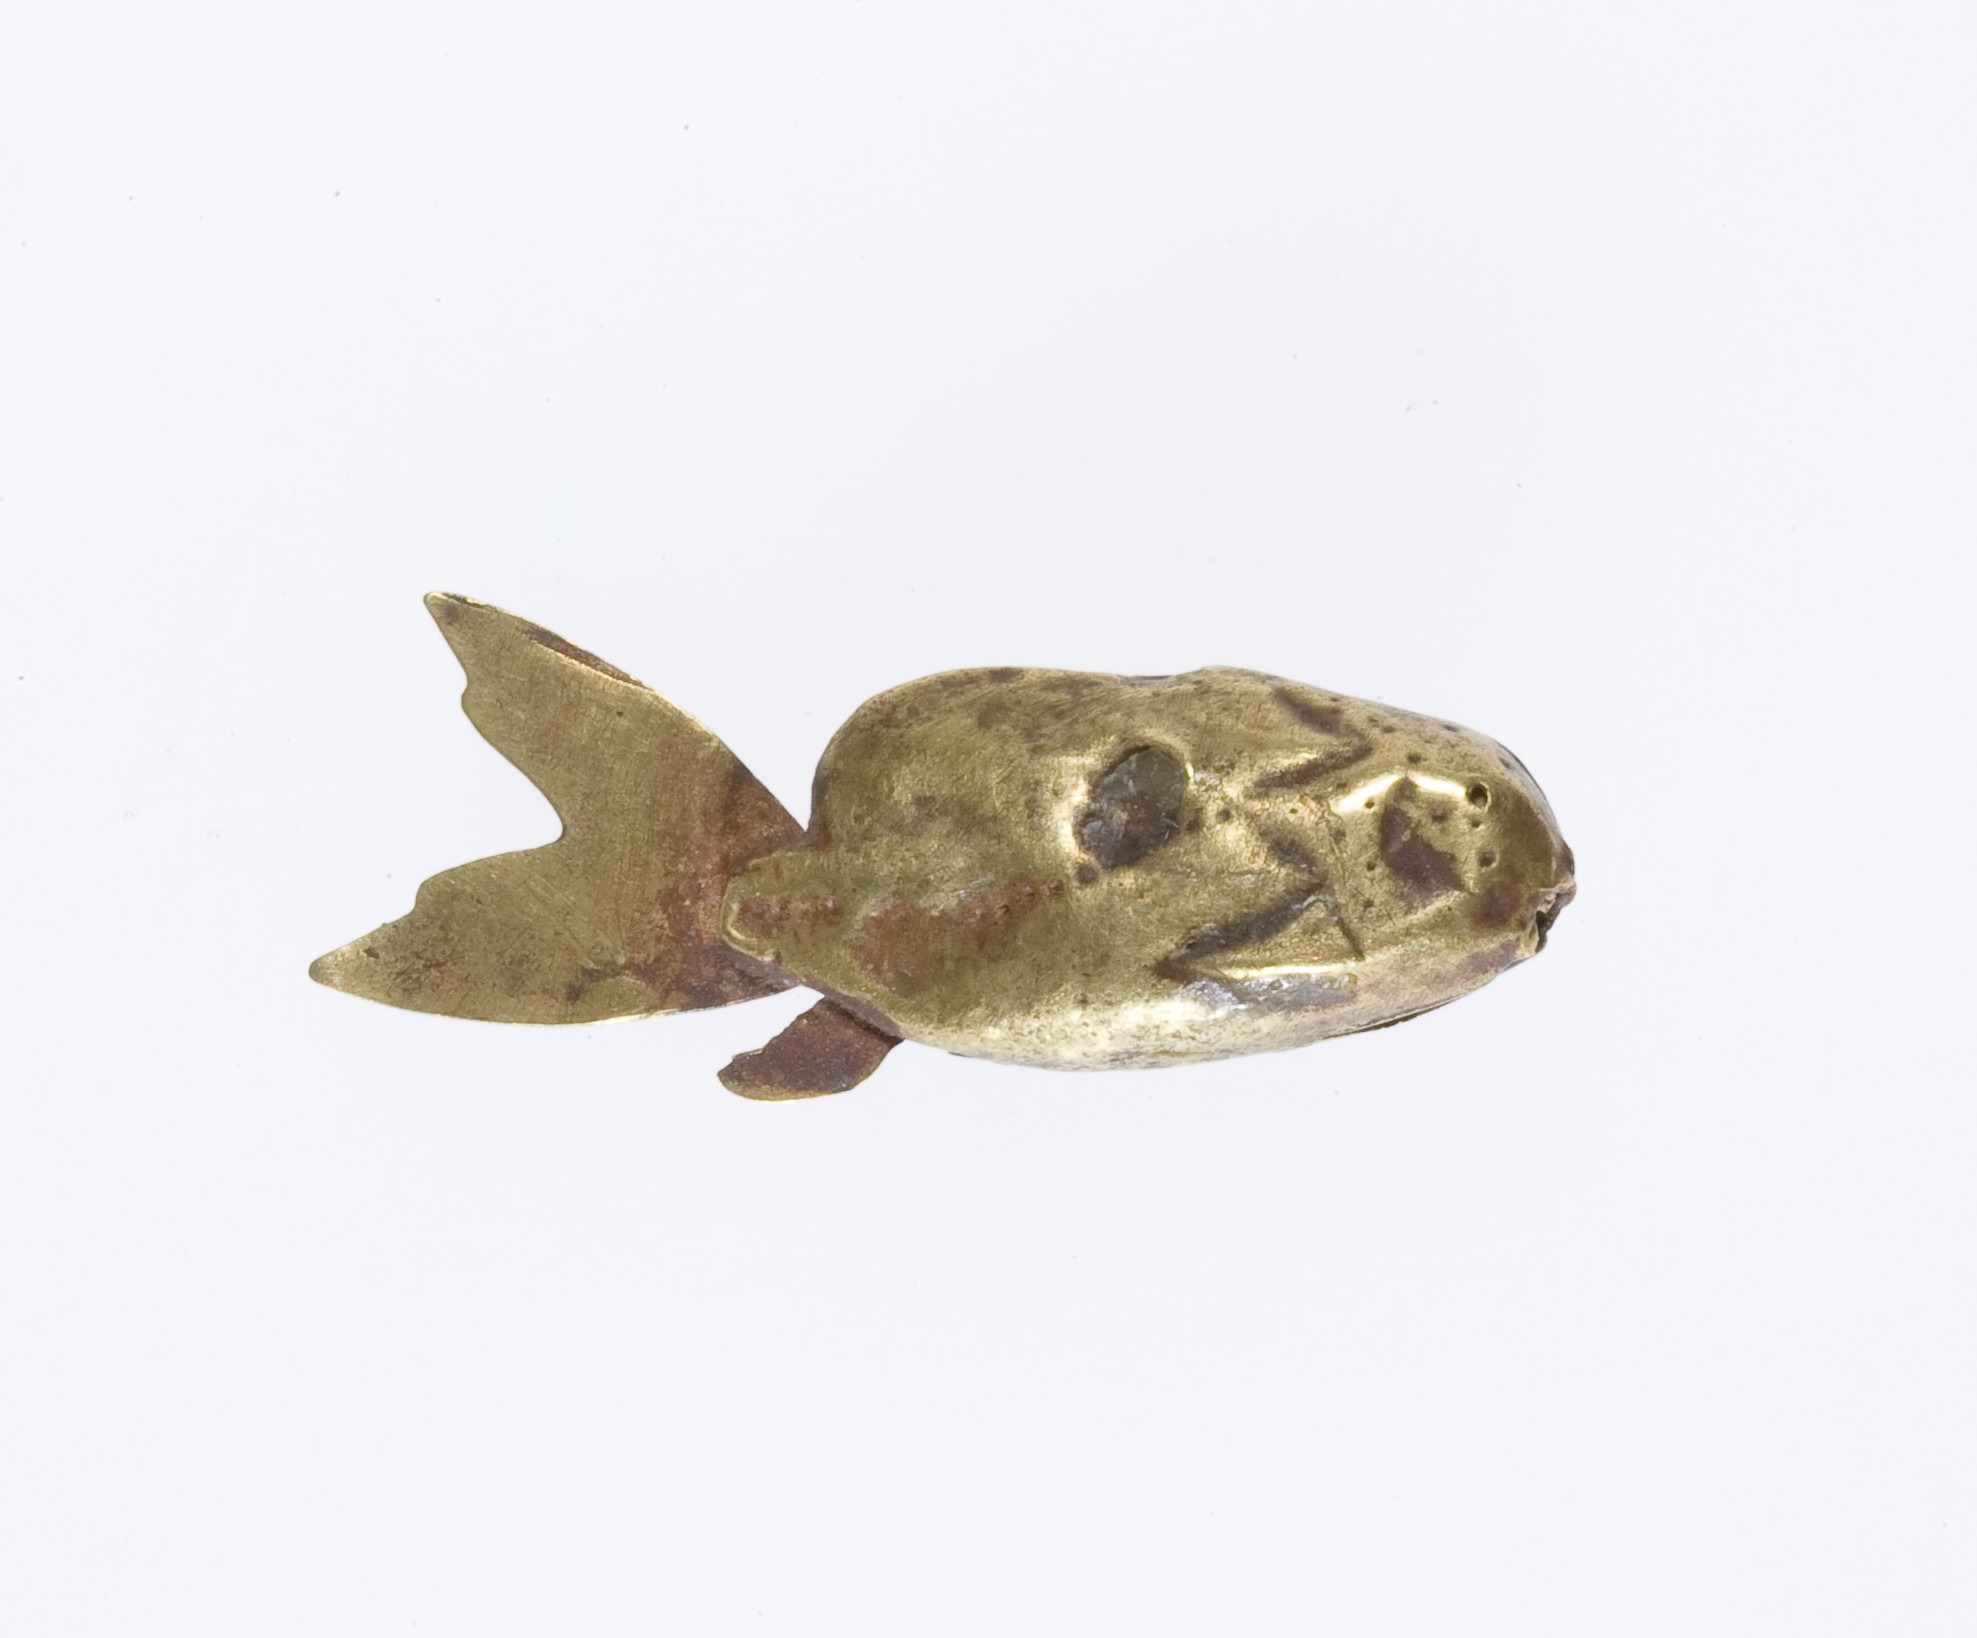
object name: amulet, fish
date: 1981-1550 BCE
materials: gold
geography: egypt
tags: fish